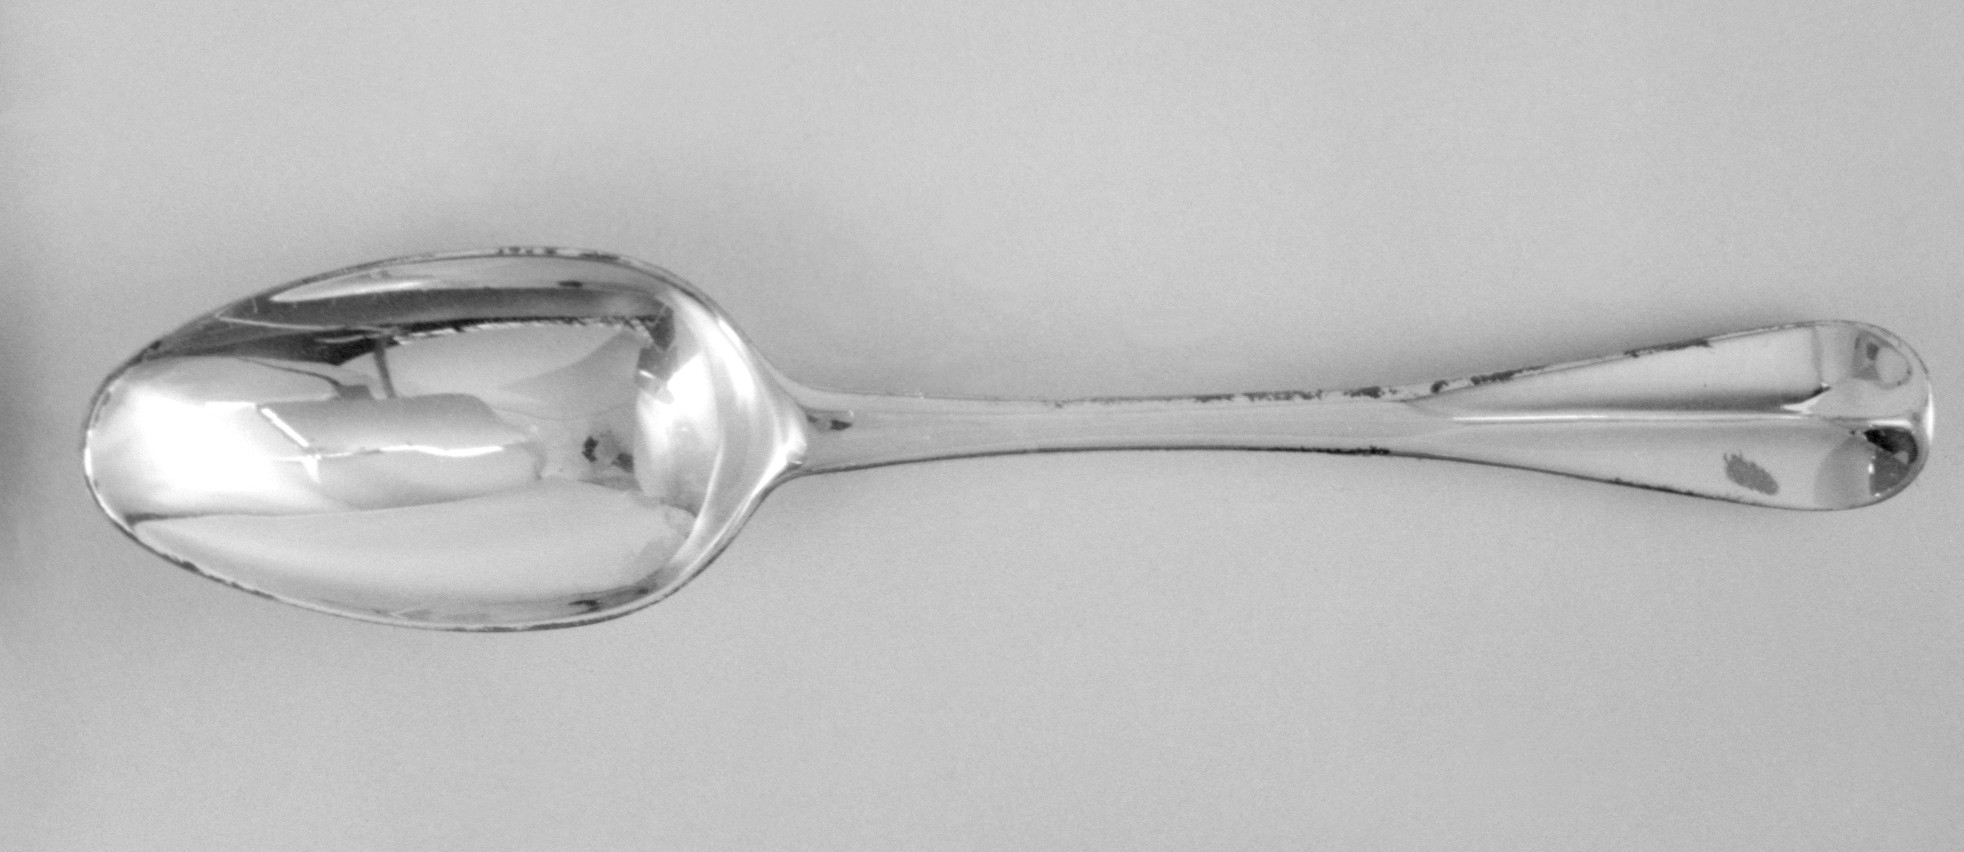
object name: spoon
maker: benjamin watts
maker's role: maker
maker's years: 1698-1727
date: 1717-1718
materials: silver